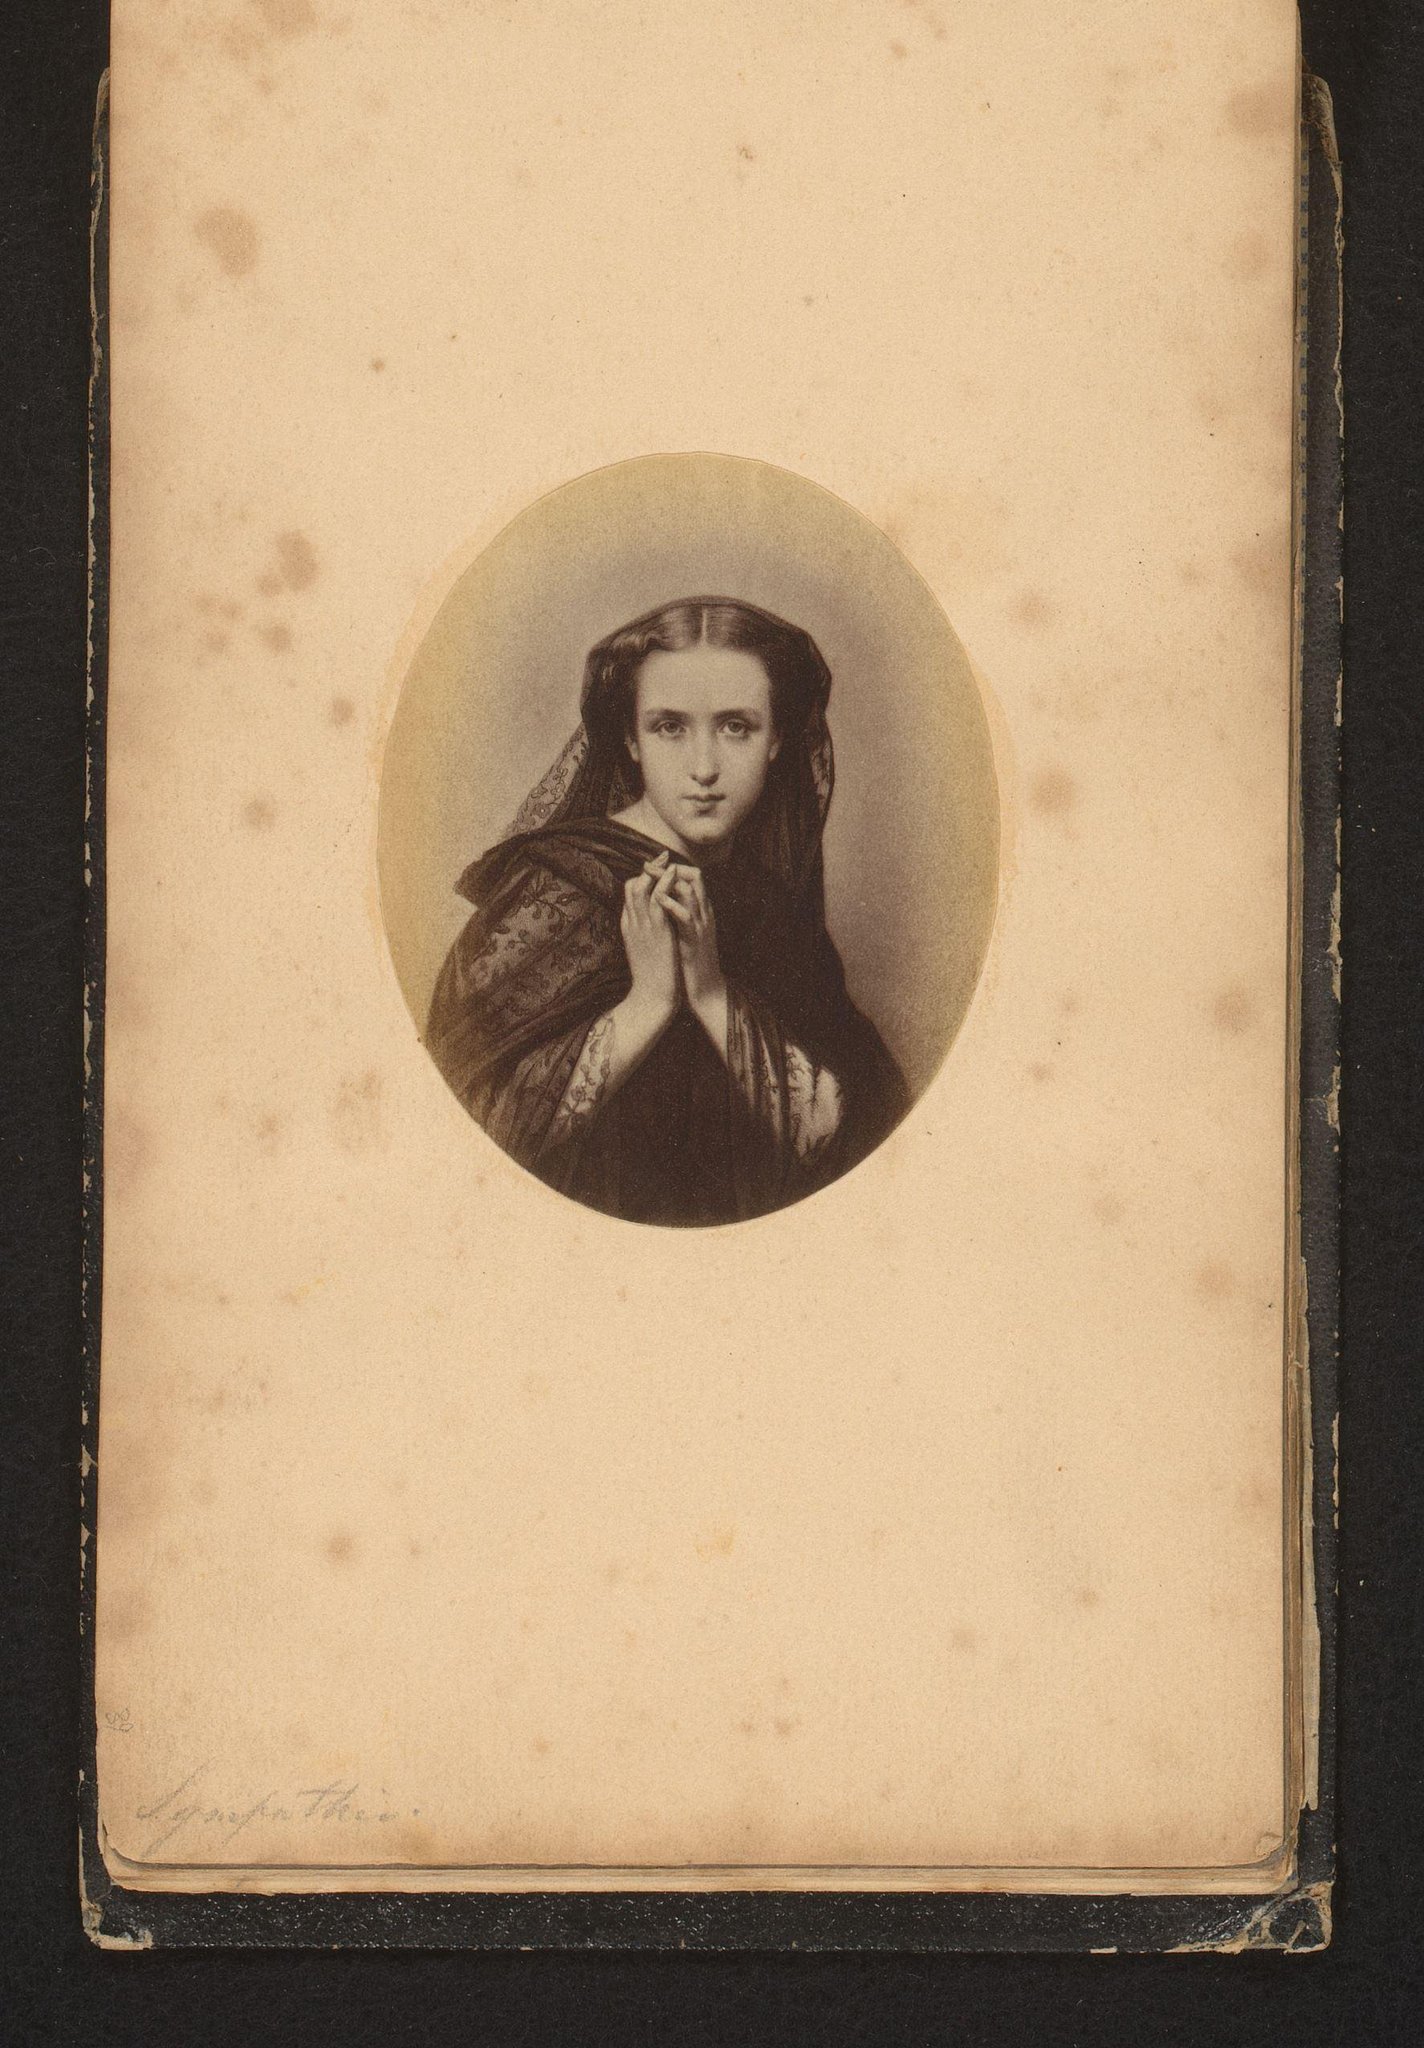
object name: reproduction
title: Fotoreproductie van een geschilderd portret van een vrouw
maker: Anonymous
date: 1860-1900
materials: photographic support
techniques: albumen print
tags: adult woman, painting, drawing and the graphic arts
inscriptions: annotation: ‘[...]’